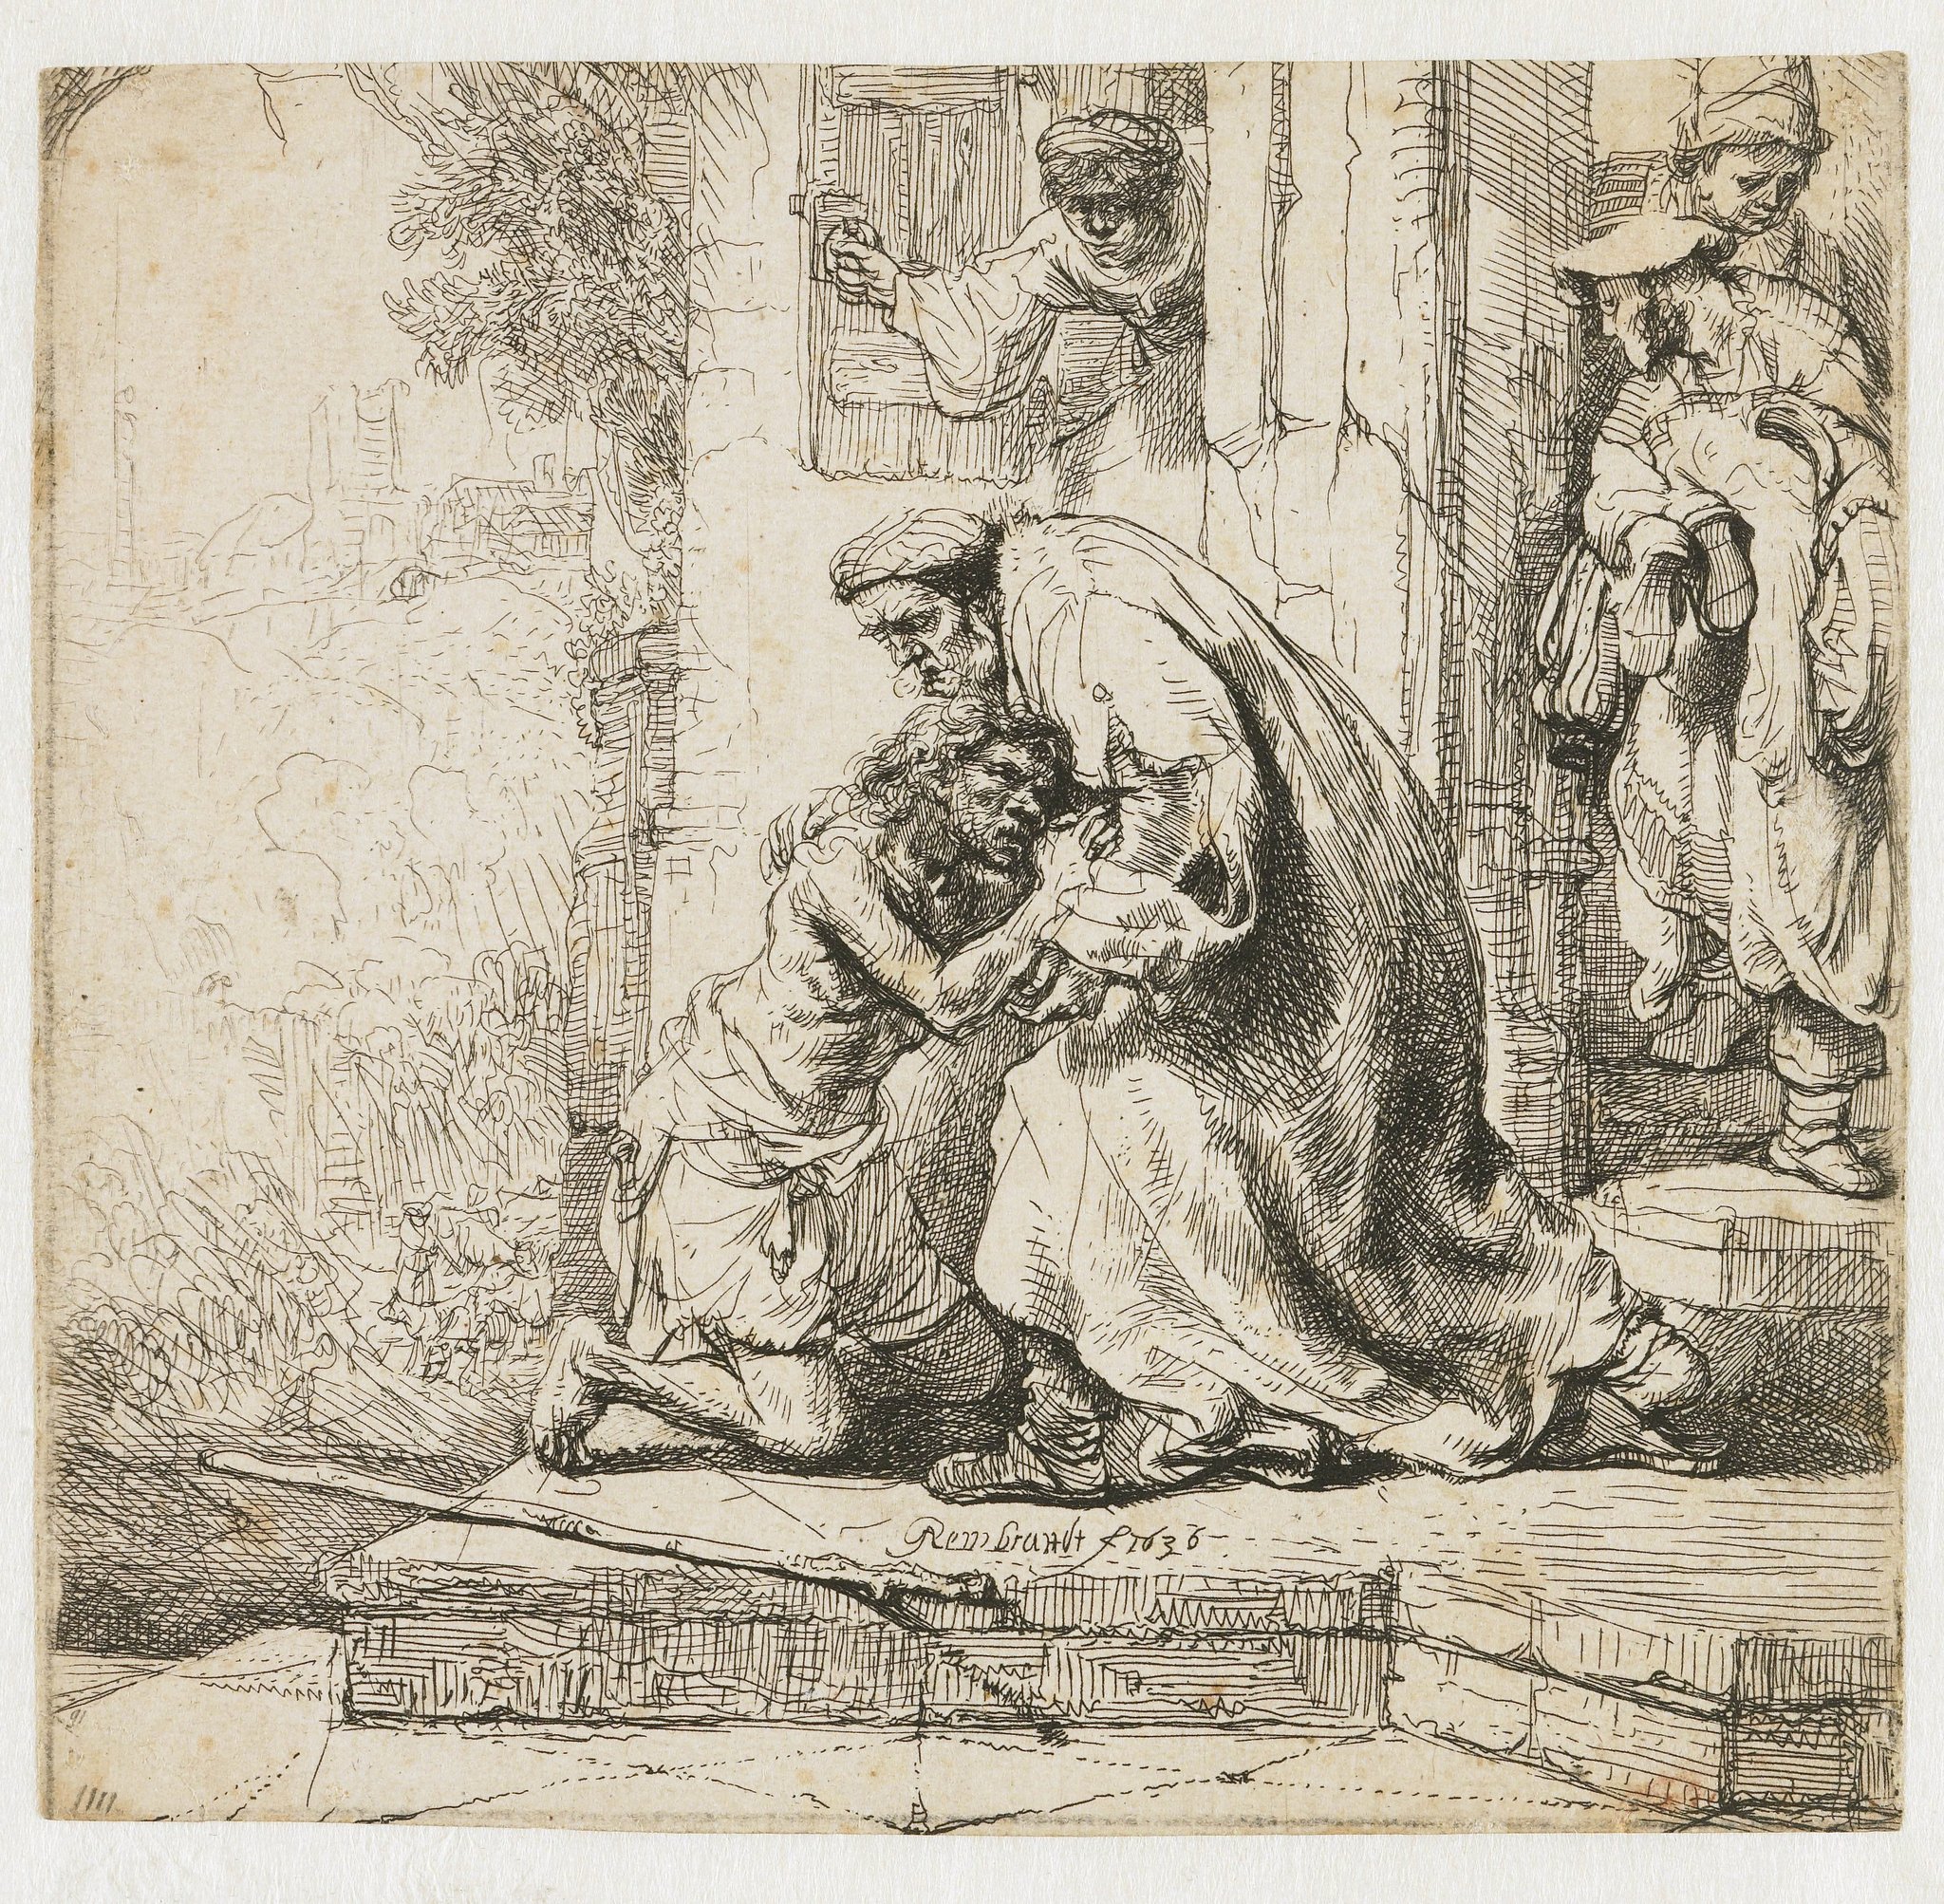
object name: print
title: The return of the prodigal son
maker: rembrandt van rijn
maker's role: draughtsman, painter, print maker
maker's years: 1606-1669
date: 1636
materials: paper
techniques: etching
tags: the prodigal son returns home, where his father awaits him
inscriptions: mark: ‘J.S (in rechthoek)’, signature and date: ‘Rembrandt f. 1636’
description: De terugkeer van de verloren zoon: hij knielt voor zijn vader op het bordes van zijn ouderlijk huis. In de deuropening twee figuren, een derde kijkt uit het venster.